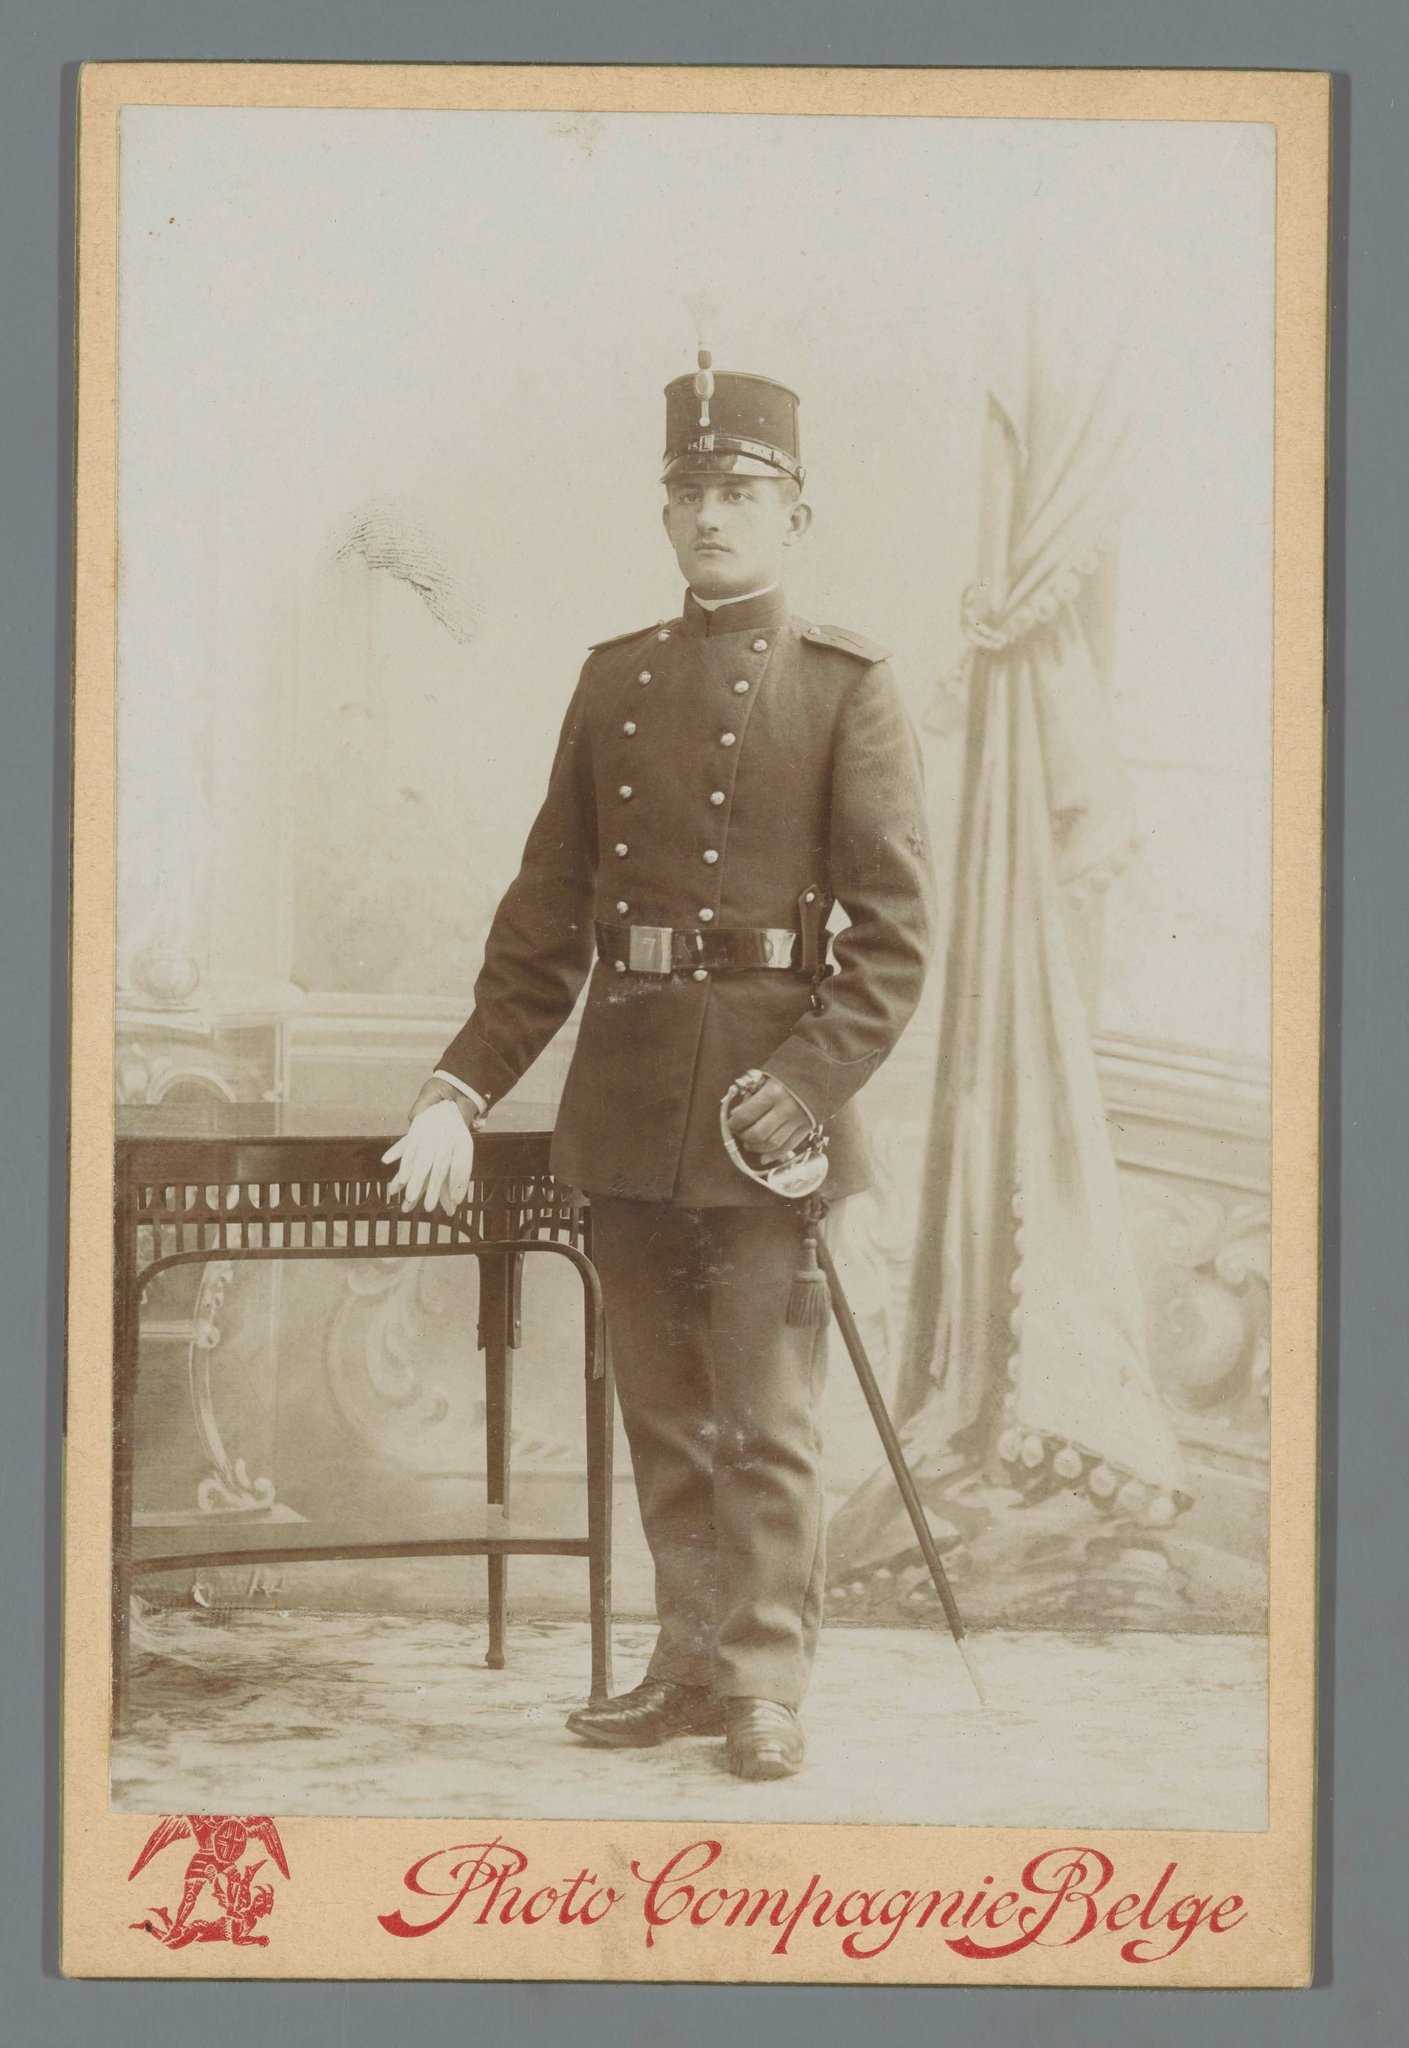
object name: photograph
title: Portret van een militair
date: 1905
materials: cardboard, photographic support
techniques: collodion silver print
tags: hacking and thrusting weapons (with name), private soldier, head-gear: cap, (military) uniforms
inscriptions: : ‘Bruxelles / 29 Juin 1905’, number: ‘46918’, : ‘Agrandissement reproductions / Les clichés son conservés’, : ‘Maison Principale: Bruxelles, 109, Rue Neuve. Succursales: Bruxelles, Ch.ée d'Ixelles, 29, Bruxelles, Rue de Flandre, 161, Anvers, Marché aux Souliers, 33’